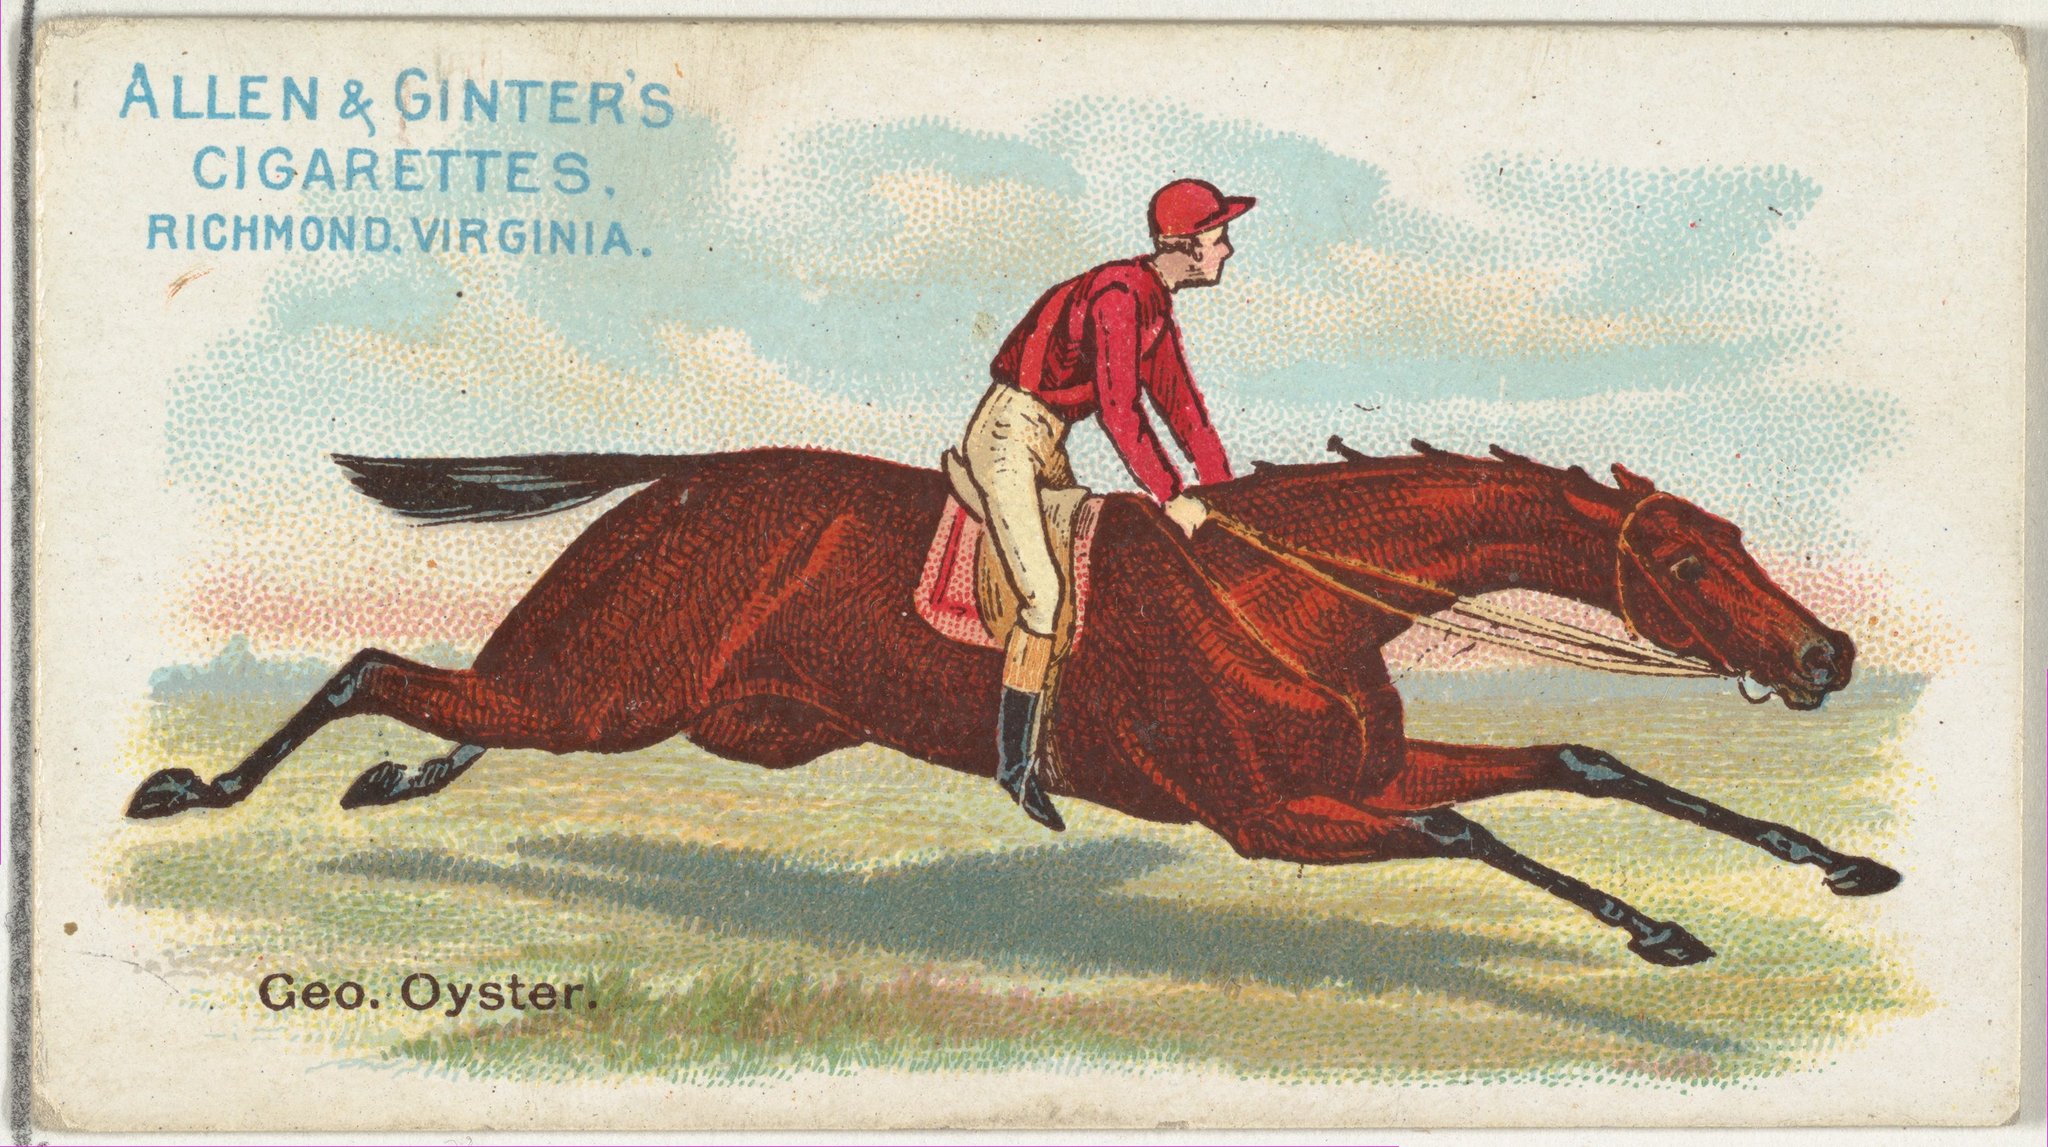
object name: print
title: George Oyster, from The World's Racers series (N32) for Allen & Ginter Cigarettes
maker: allen & ginter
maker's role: publisher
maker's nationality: american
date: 1888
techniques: color lithograph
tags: men,horses,jockeys